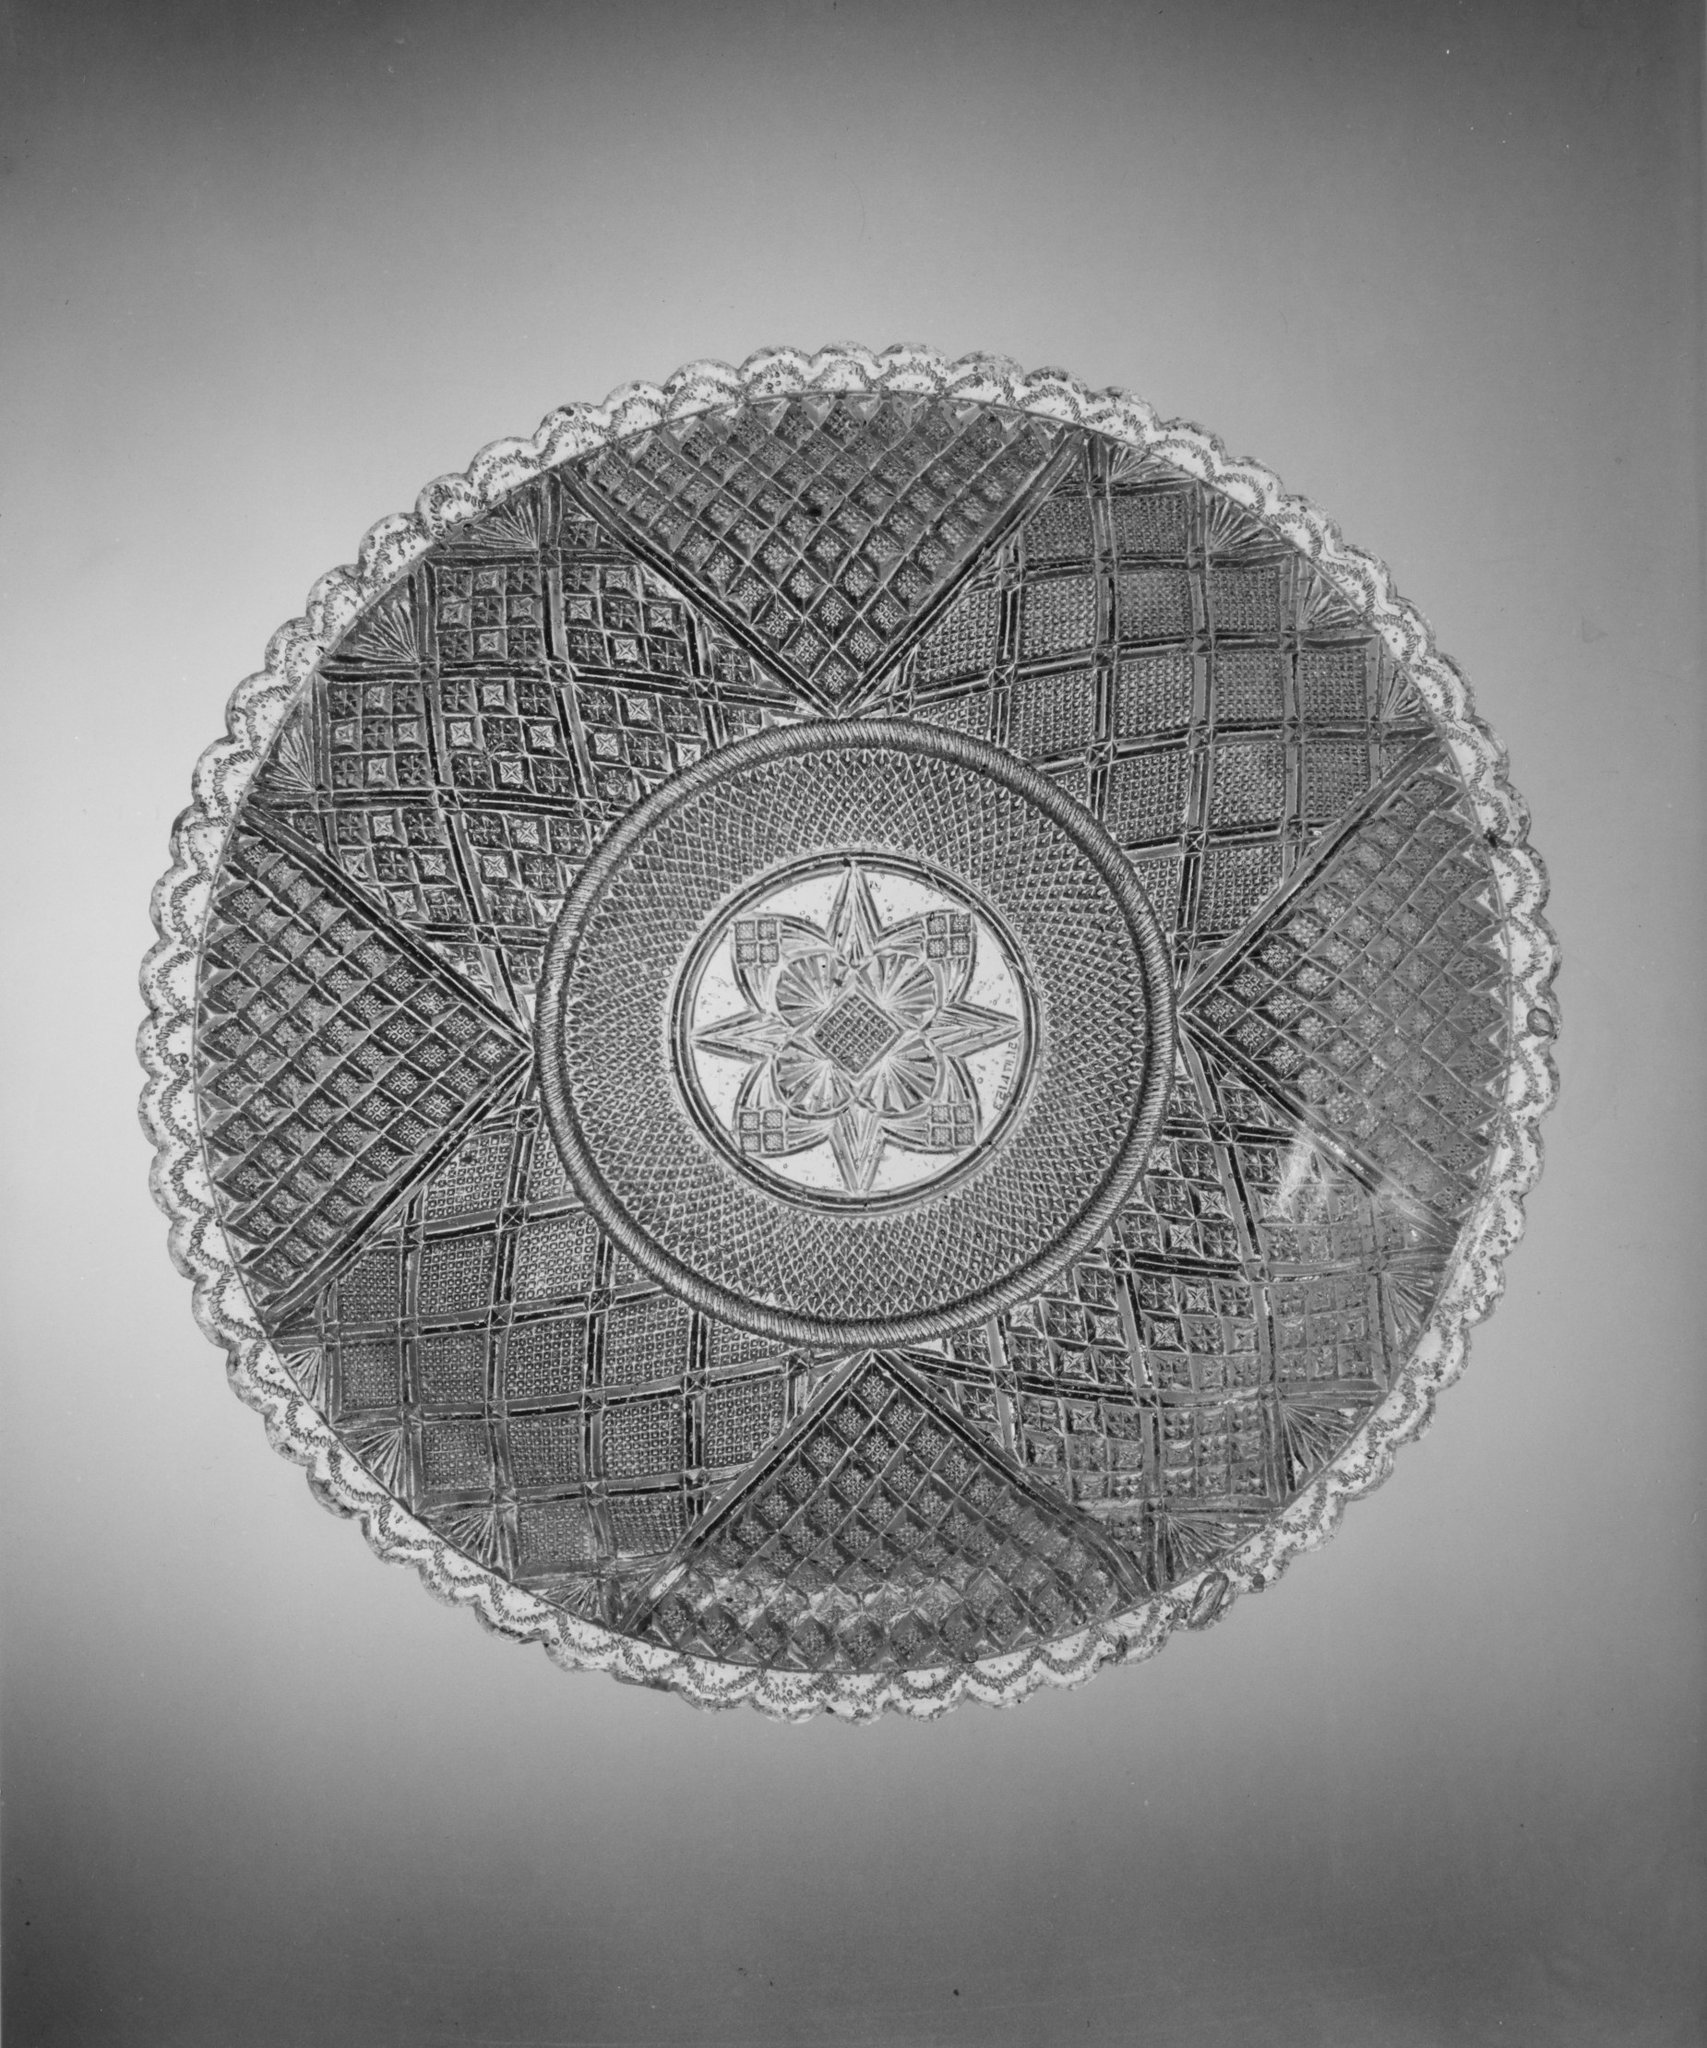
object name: bowl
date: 1830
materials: glass